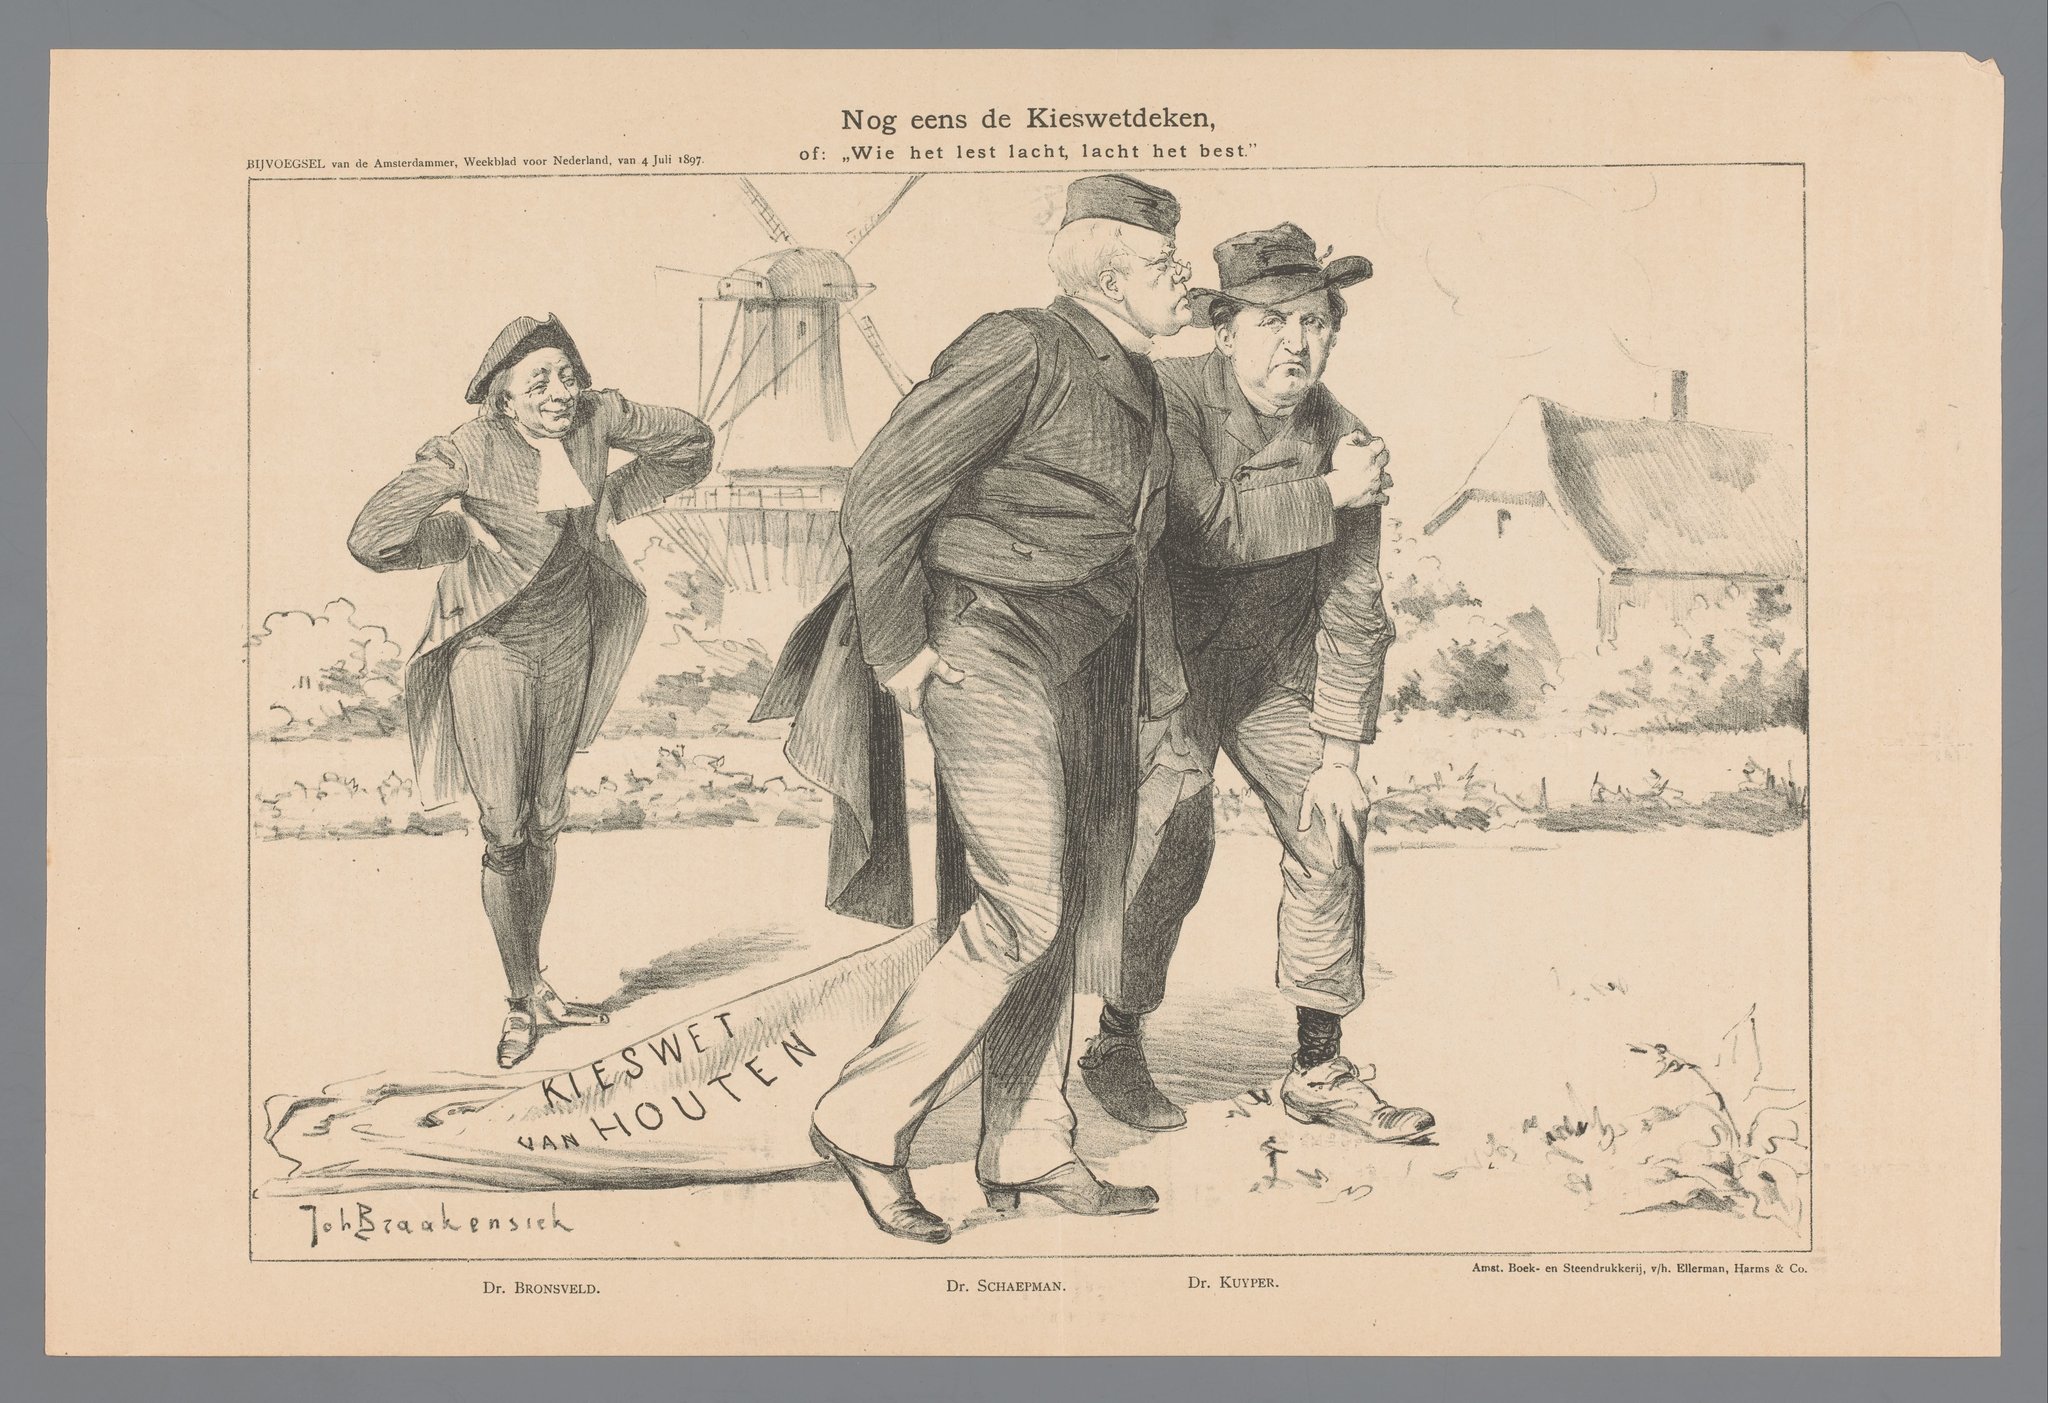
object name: cartoon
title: Nog eens de Kieswetdeken, of: "Wie het lest lacht, lacht het best"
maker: johan braakensiek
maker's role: draughtsman, print maker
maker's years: 1858-1940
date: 1897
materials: paper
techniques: lithograph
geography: amsterdam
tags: the hague, abraham kuyper, rome, priest, herman johannes aloysius maria schaepman, utrecht, politician, samuel van houten, voting, election, historical persons, laughing, windmill in landscape, politician, e.g. party leader, political caricatures and satires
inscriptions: date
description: Prent uit het bijvoegsel van: De Amsterdammer. Weekblad voor Nederland, 4 juli 1897.